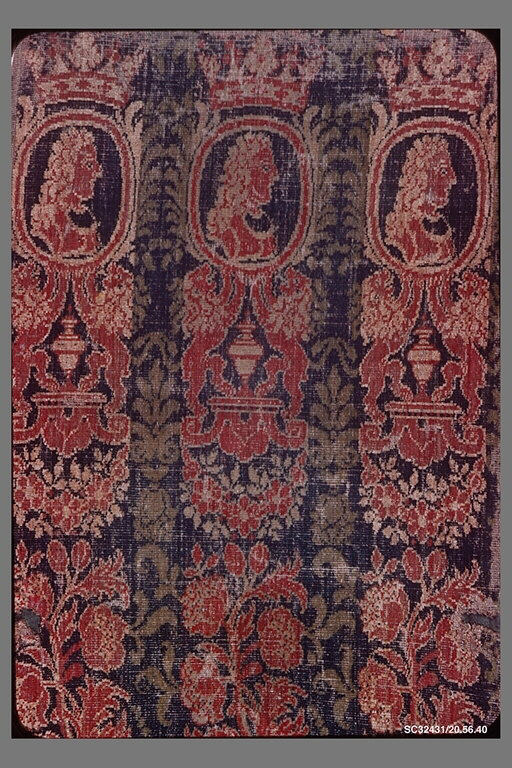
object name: piece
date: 1701-1733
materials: hemp, linen, wool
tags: profiles,lions,flowers,leaves